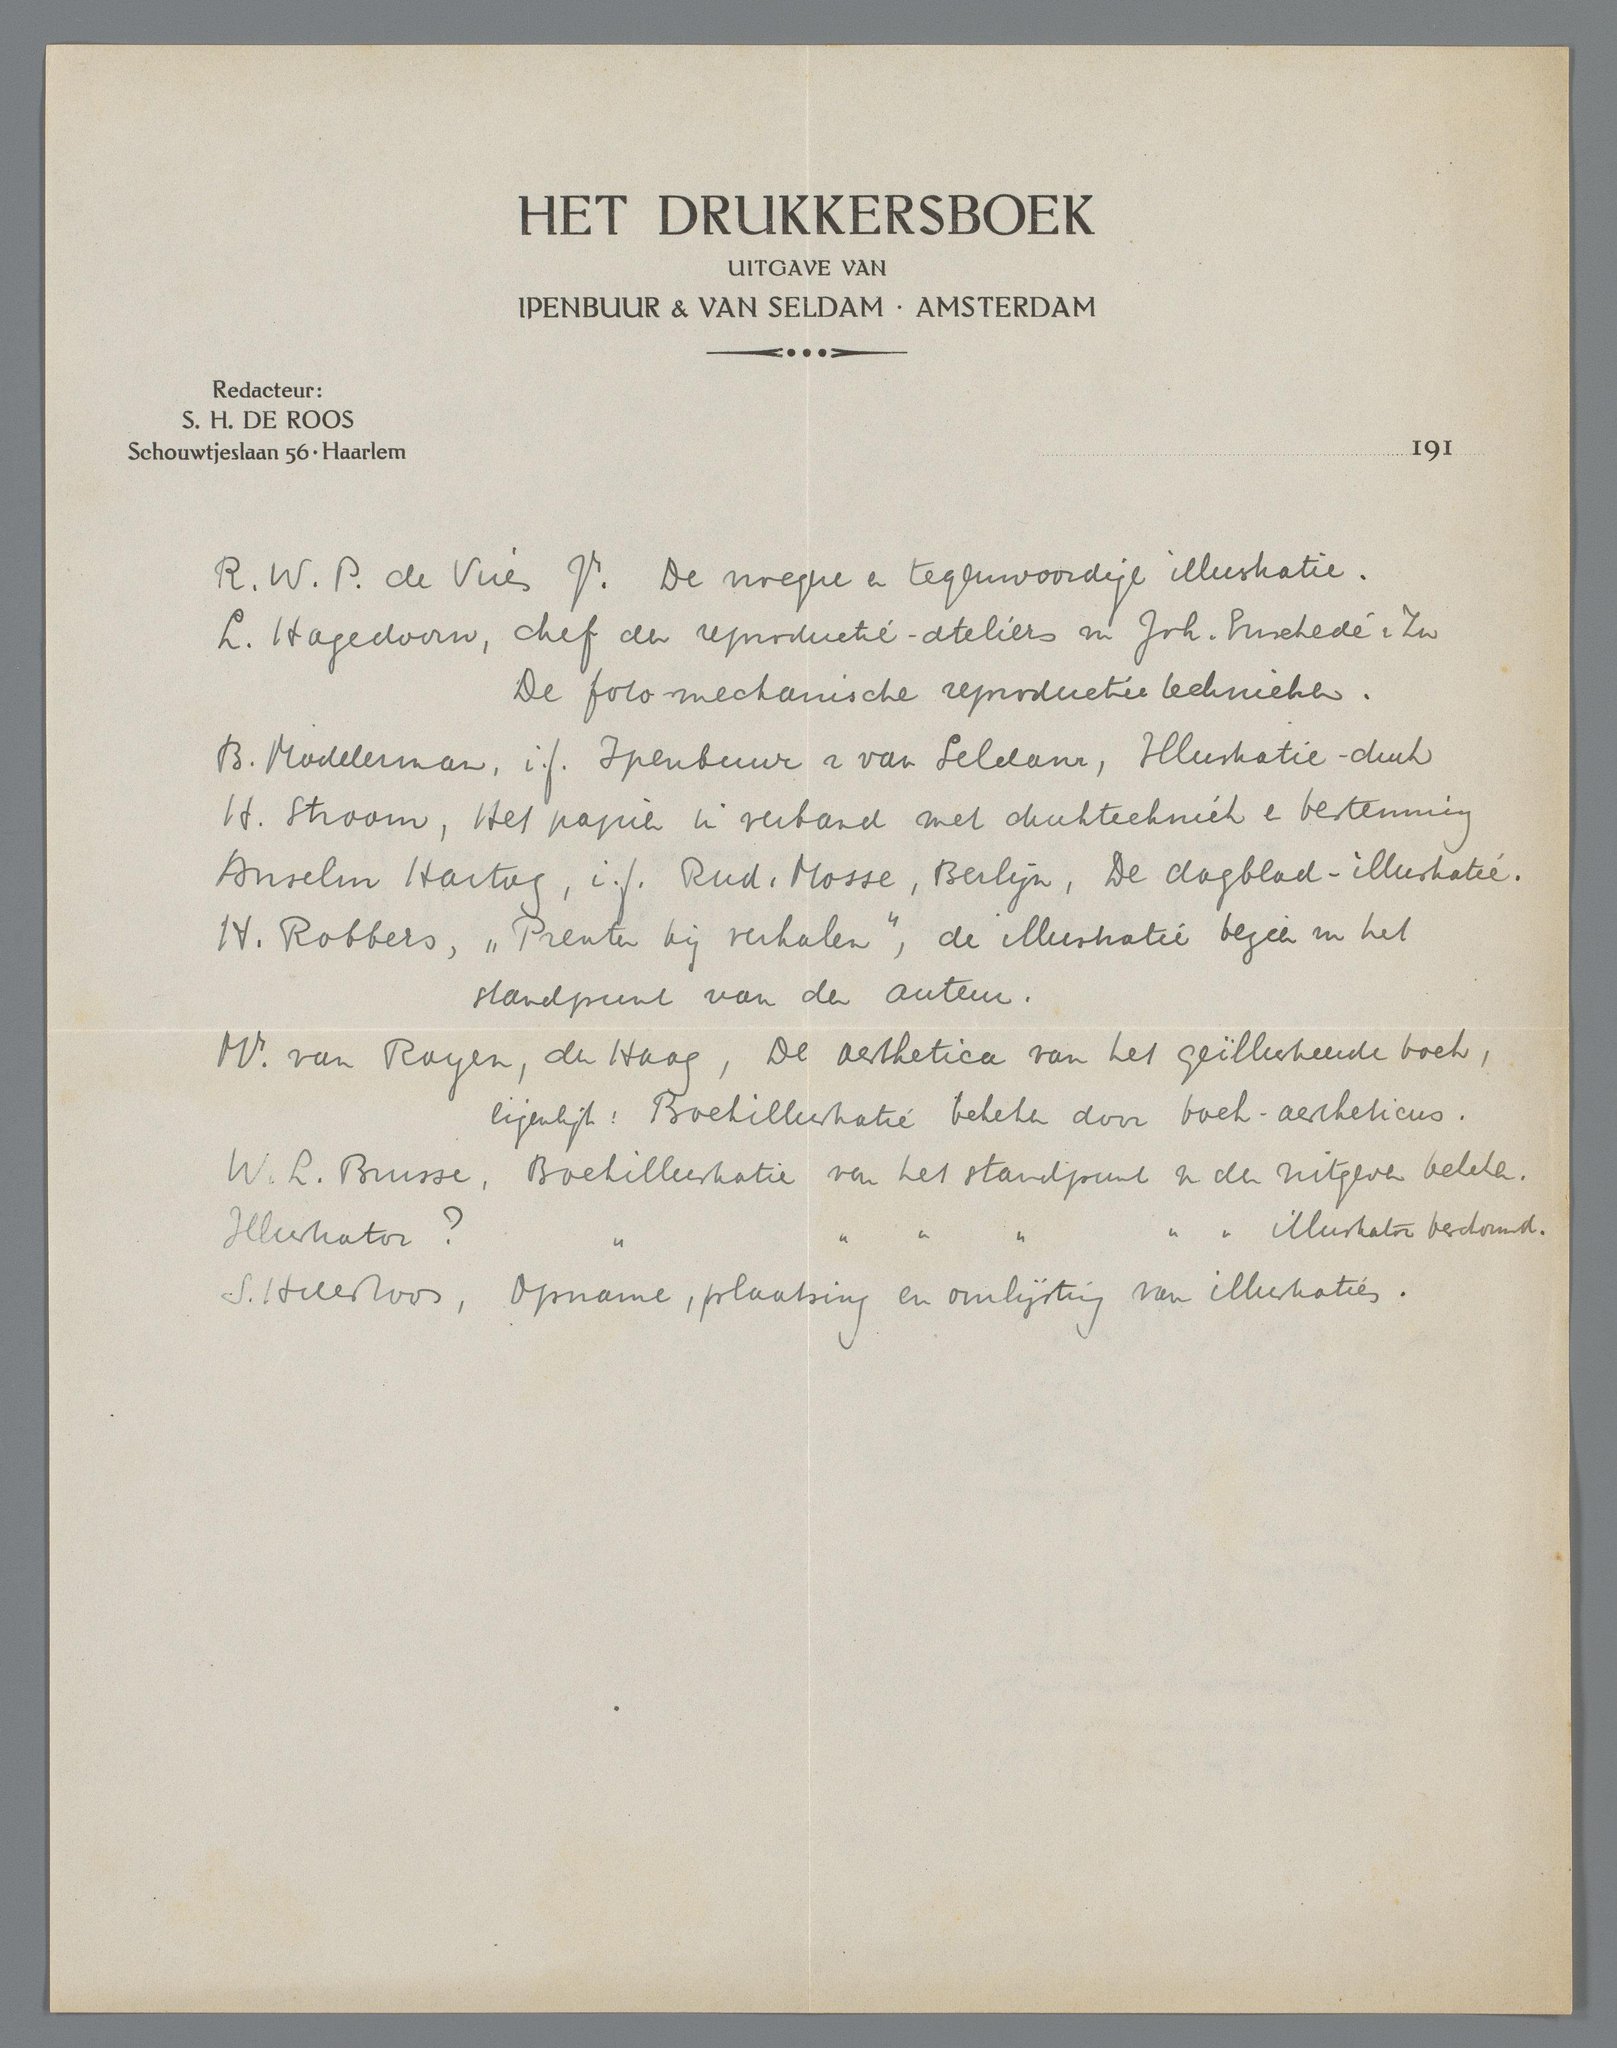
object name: text sheet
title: Briefpapier van Het Drukkersboek (onbekend jaar), uitgegeven door Ipenbuur & Van Seldam te Amsterdam, met handgeschreven overzicht van de inhoud, redacteur S.H. de Roos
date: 1910-1919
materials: paper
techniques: handwriting, pen, printing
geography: amsterdam